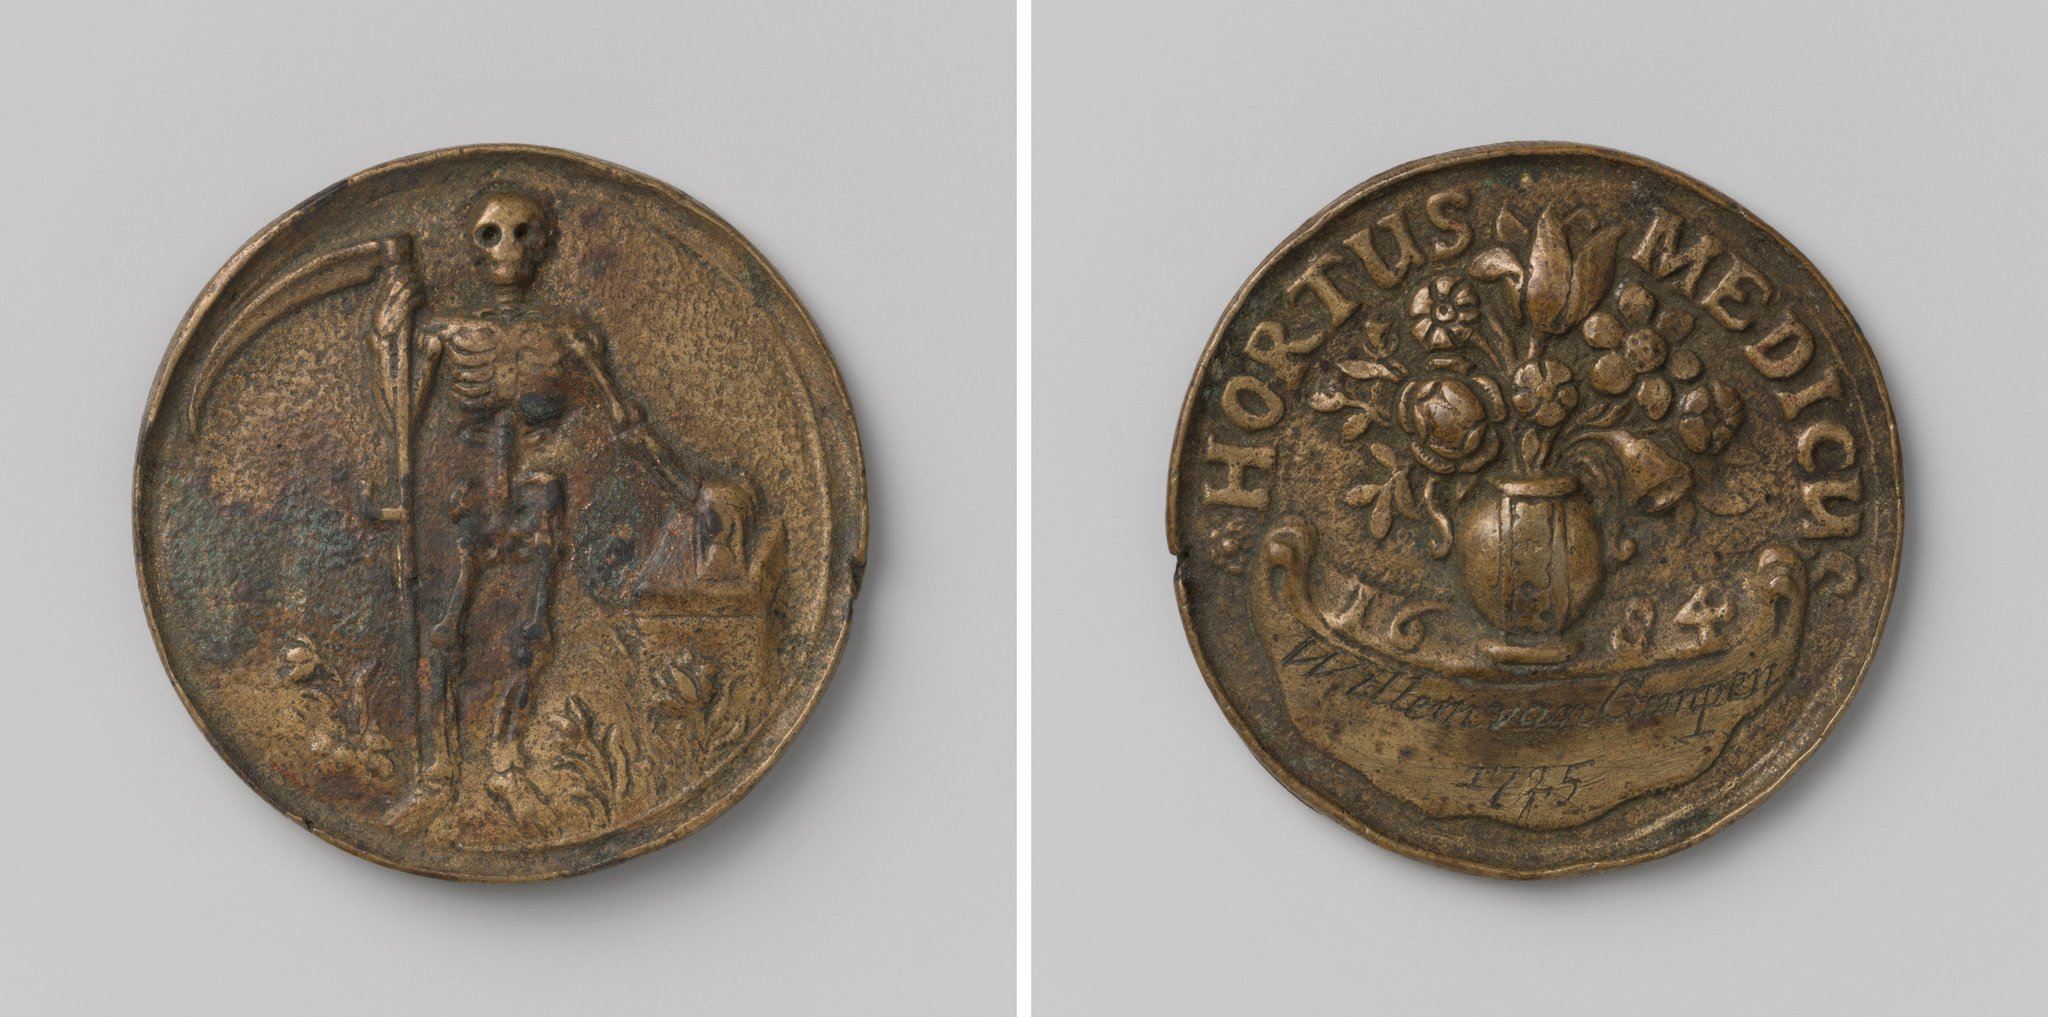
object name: toegangspenning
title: Chirurgijnsgilde te Amsterdam, toegangspenning voor de hortus medicus van Willem van Campen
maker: Anonymous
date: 1725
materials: brass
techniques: casting, engraving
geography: amsterdam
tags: amsterdam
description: Messing penning. Voorzijde: Dood, afgebeeld als geraamte, in bloemenveld met zeis in rechterhand en met linkerhand op zandloper, die op sokkel staat. Keerzijde:vaas met bloemen tussen jaartal; op vaas:wapenschild boven cartouche met opschrift binnen omschrift.